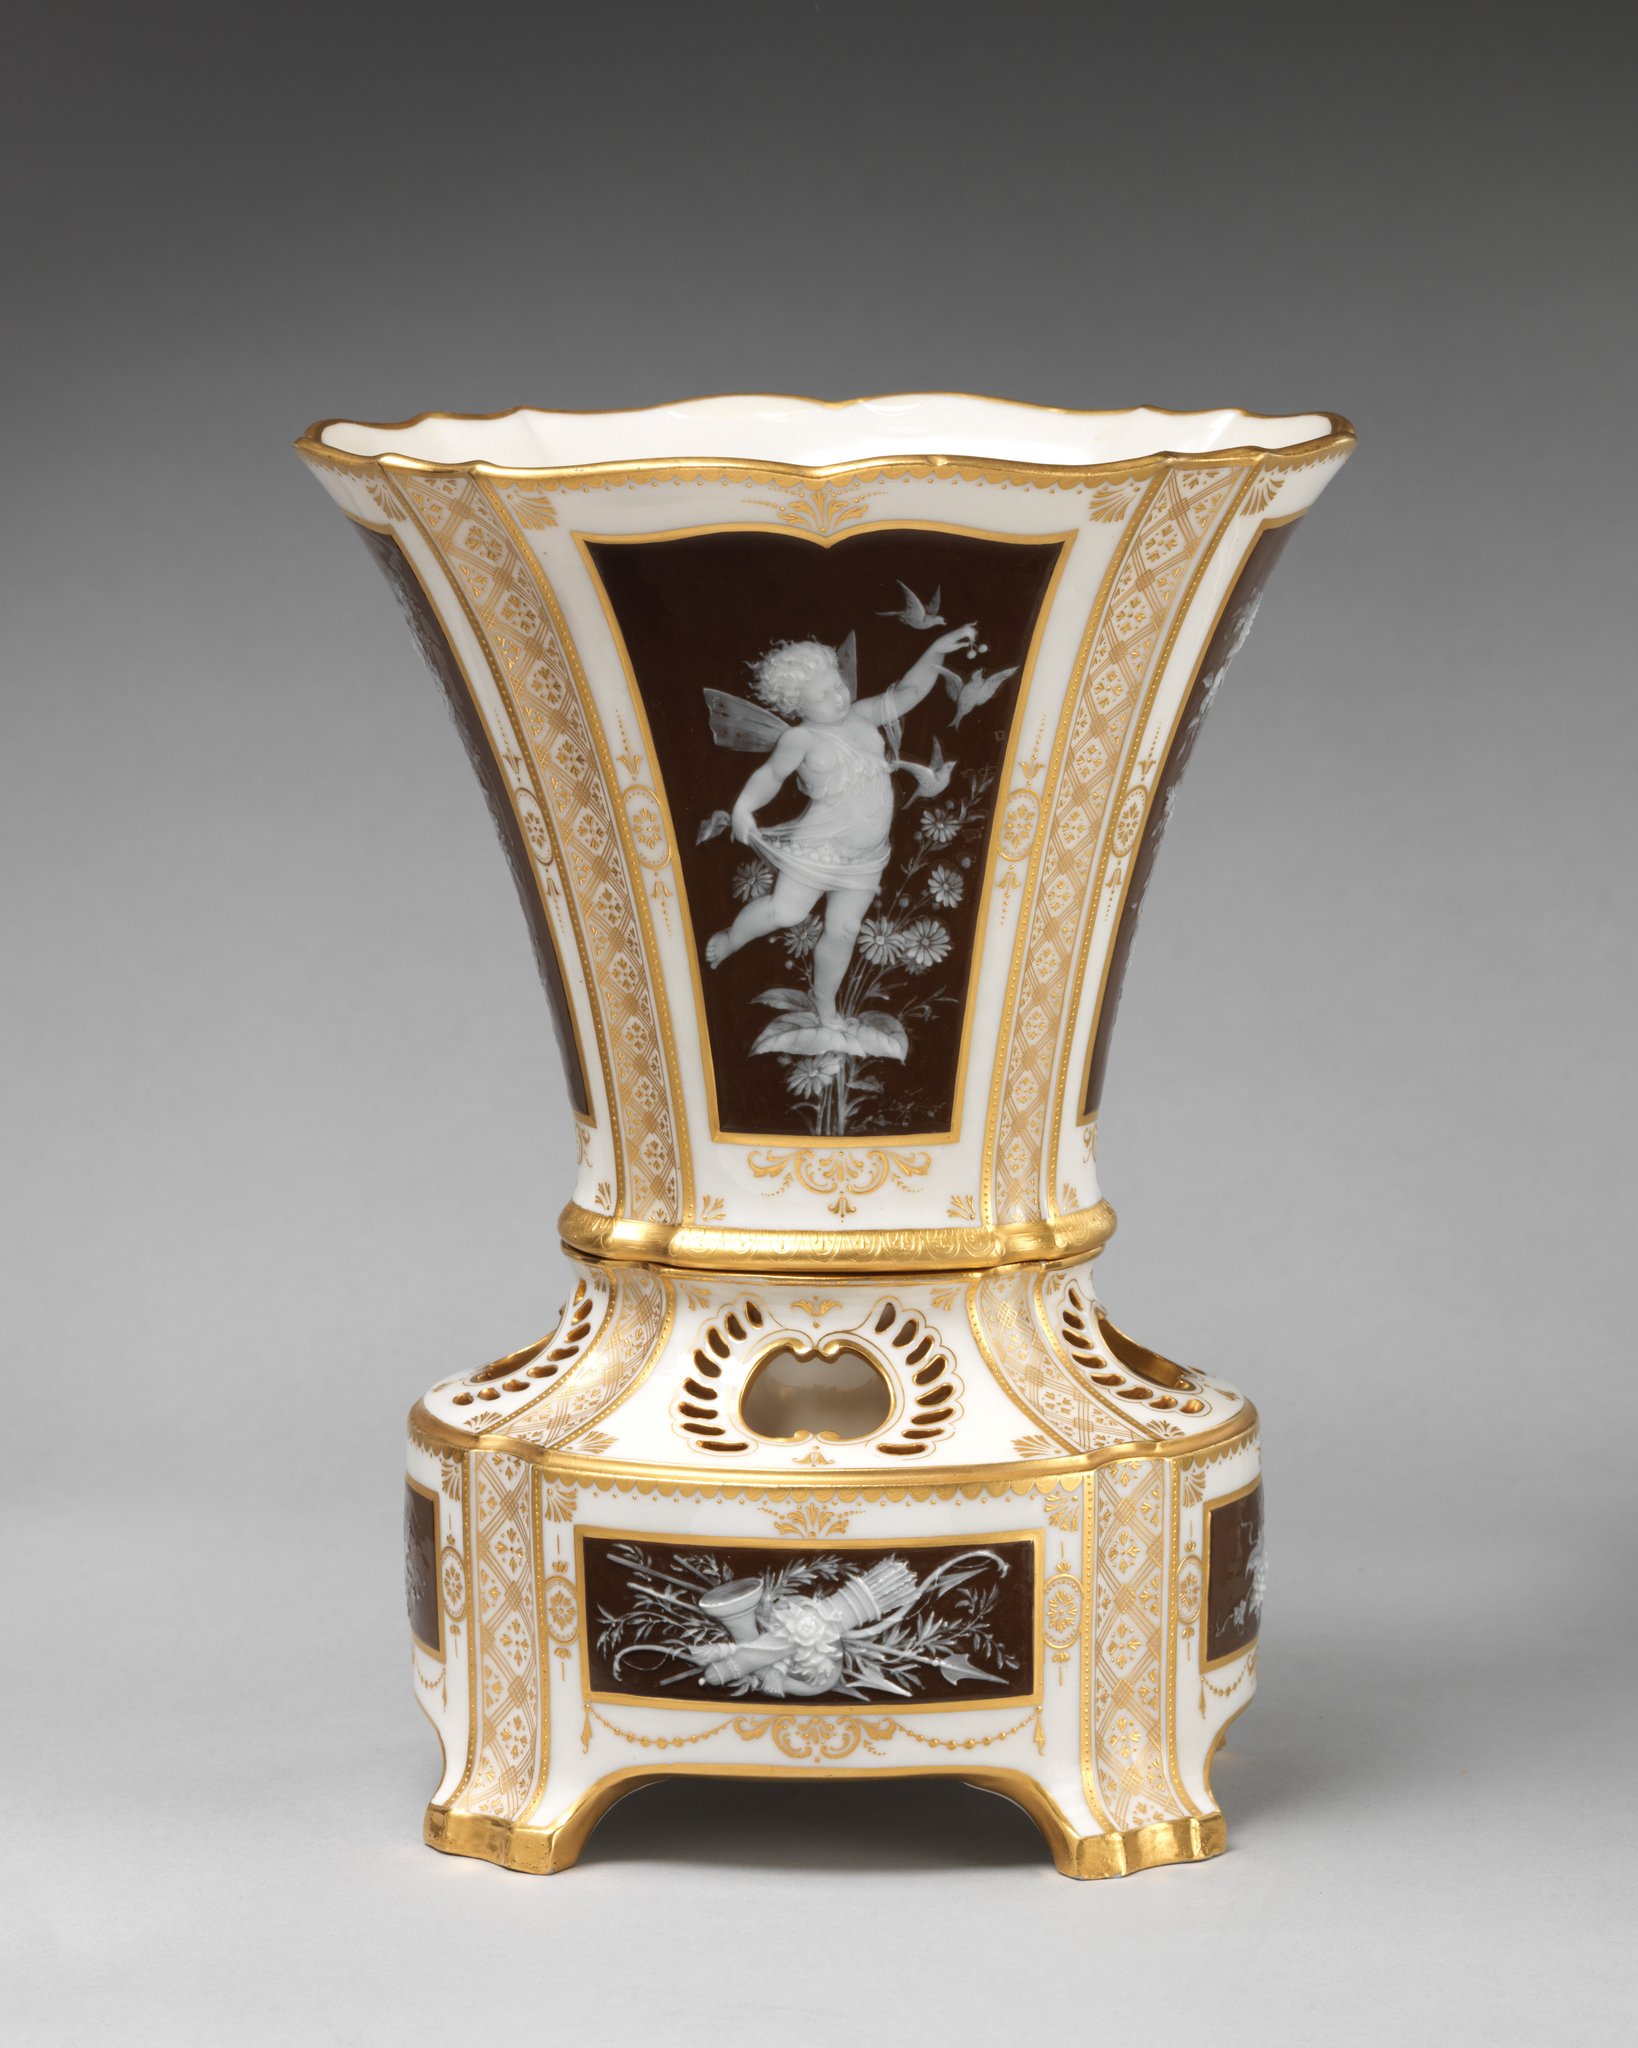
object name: bulb vase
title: Bulb Vase (one of a pair)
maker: minton(s)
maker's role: maker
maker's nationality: british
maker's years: 1793-2001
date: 1889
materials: bone china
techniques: gilding